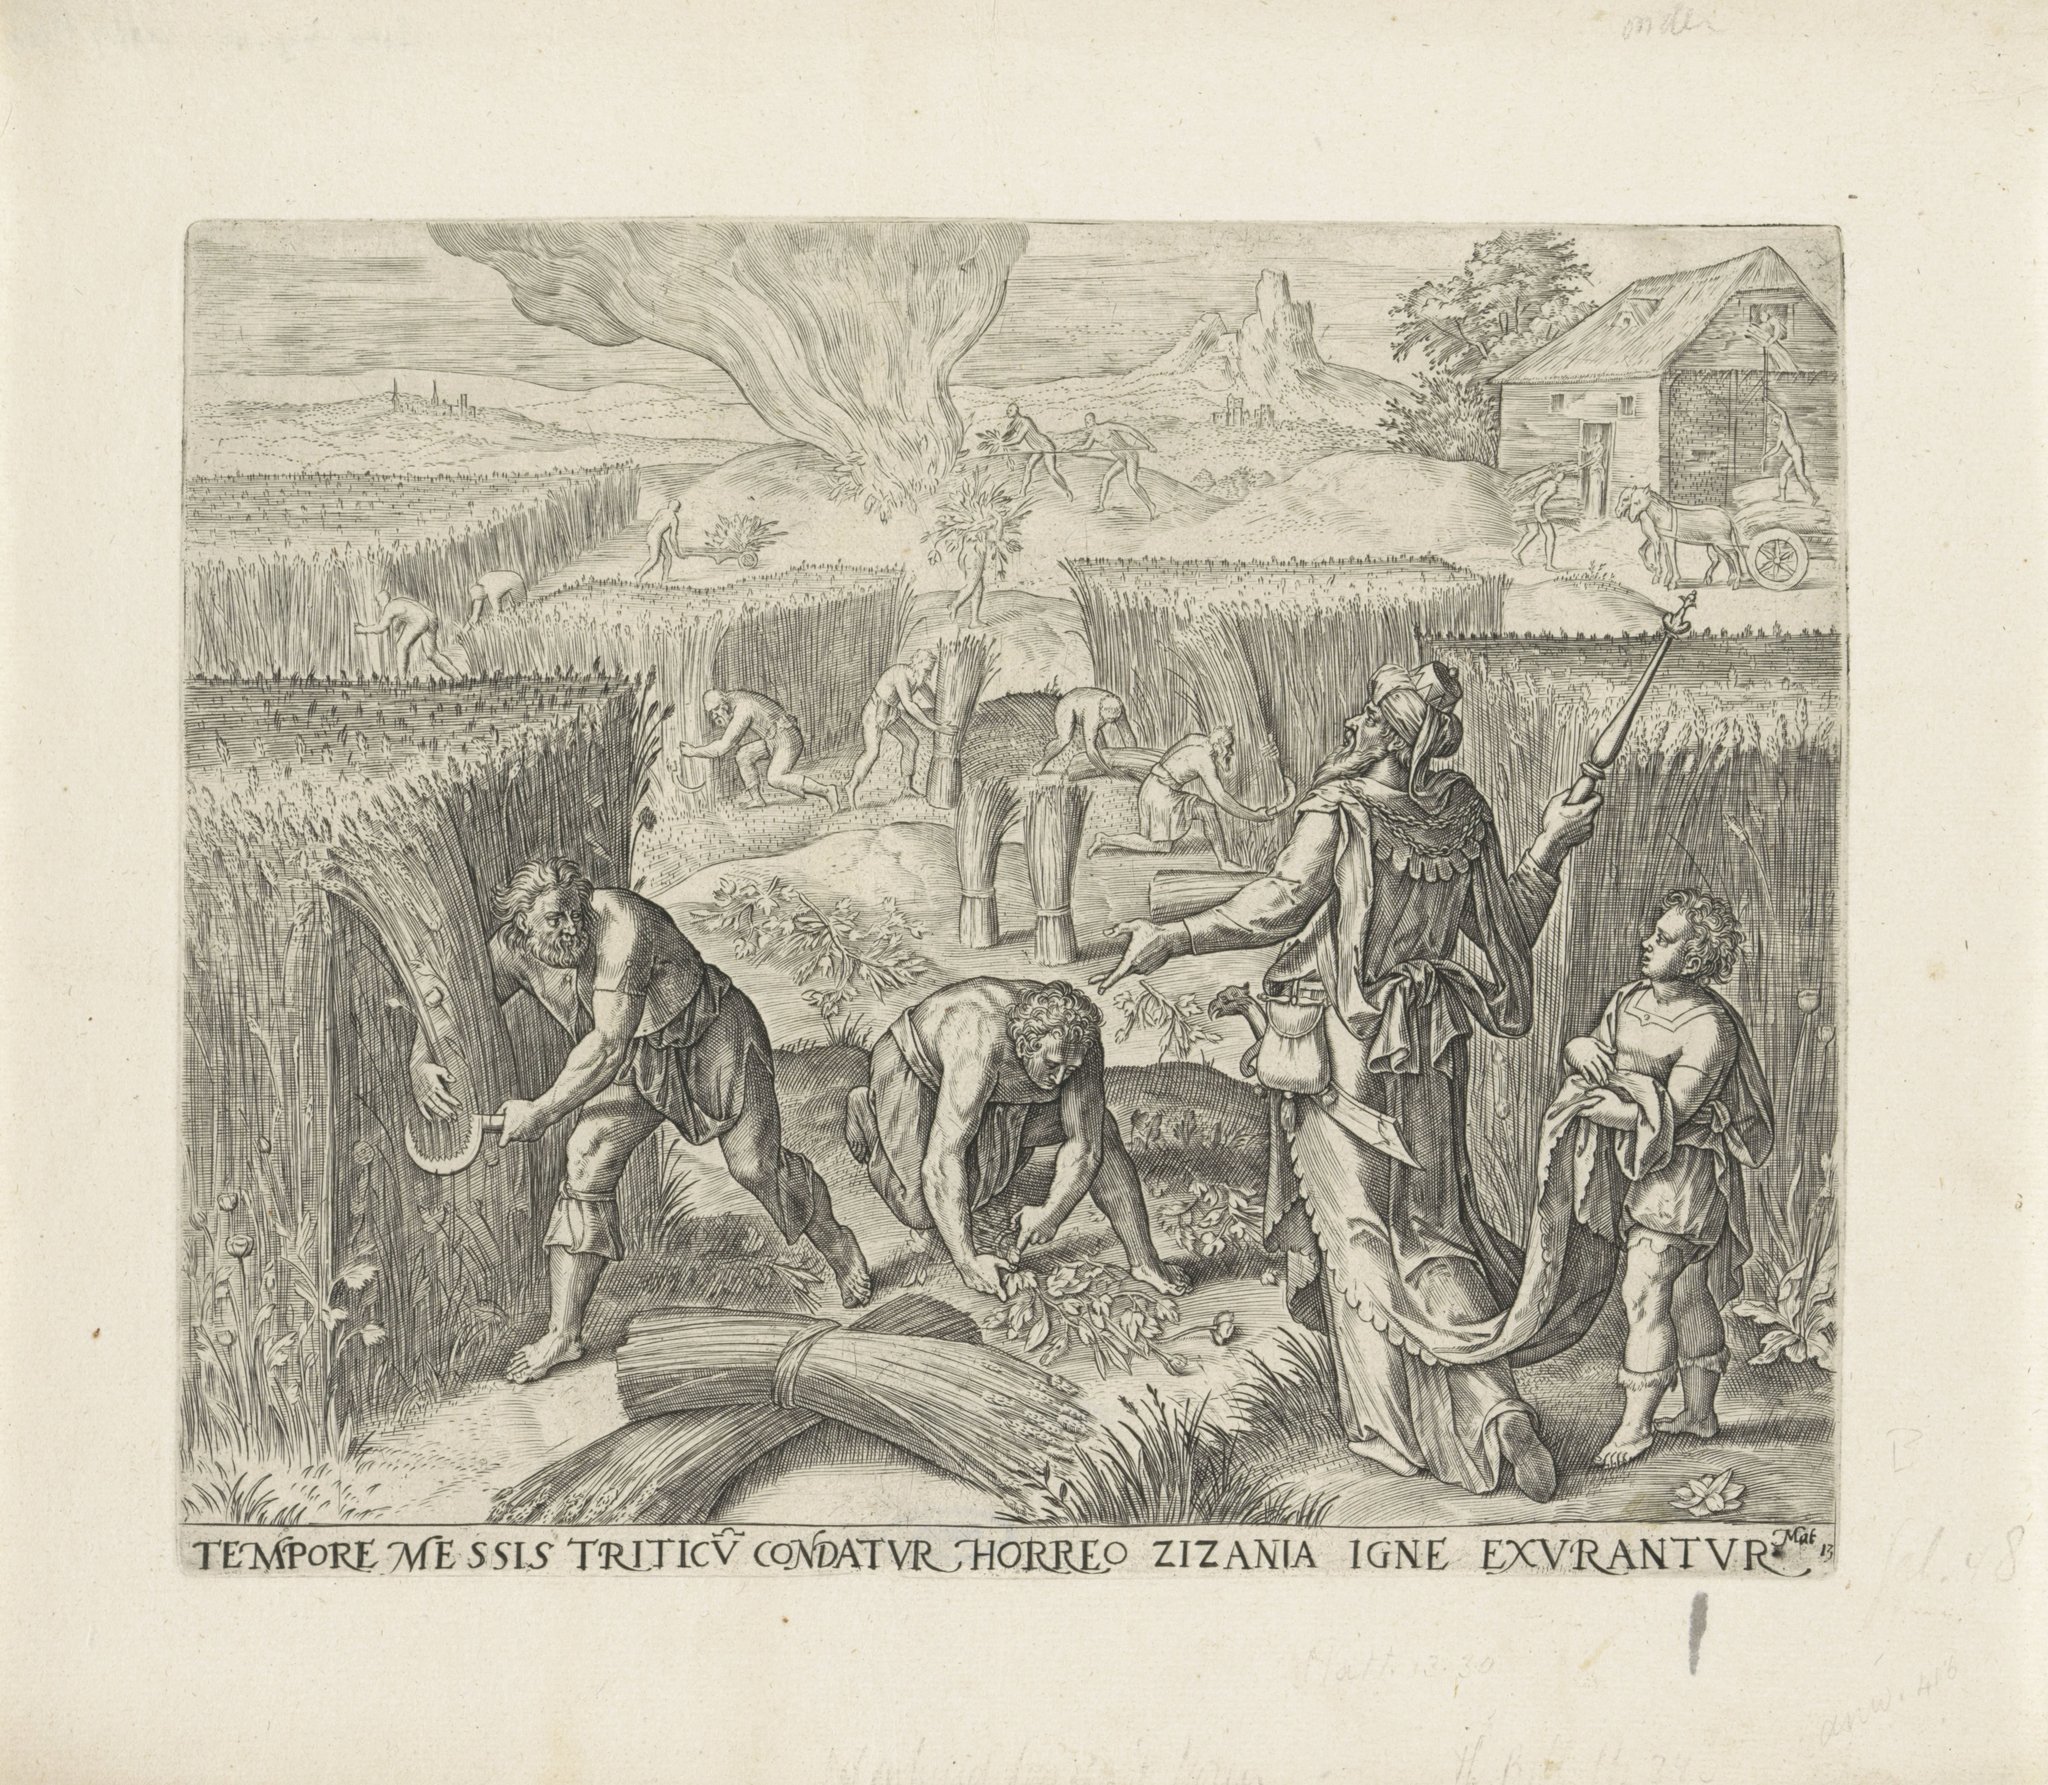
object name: print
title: Het verbranden van het onkruid en oogsten van het graan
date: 1579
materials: paper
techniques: engraving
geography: antwerp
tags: in time of the harvest the tares are bound and burned, but the wheat is gathered and put in the barn of the lord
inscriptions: collector's mark: Lugt 2228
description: De landheer, met een scepter in de hand, geeft de opdracht om de oogst binnen te halen. Het graan wordt geoogst en het onkruid wordt verzameld en verbrand. Een jongen houdt het kleed van de landheer vast. Onder de voorstelling een verwijzing in het Latijn naar de Bijbeltekst in Mat. 13.